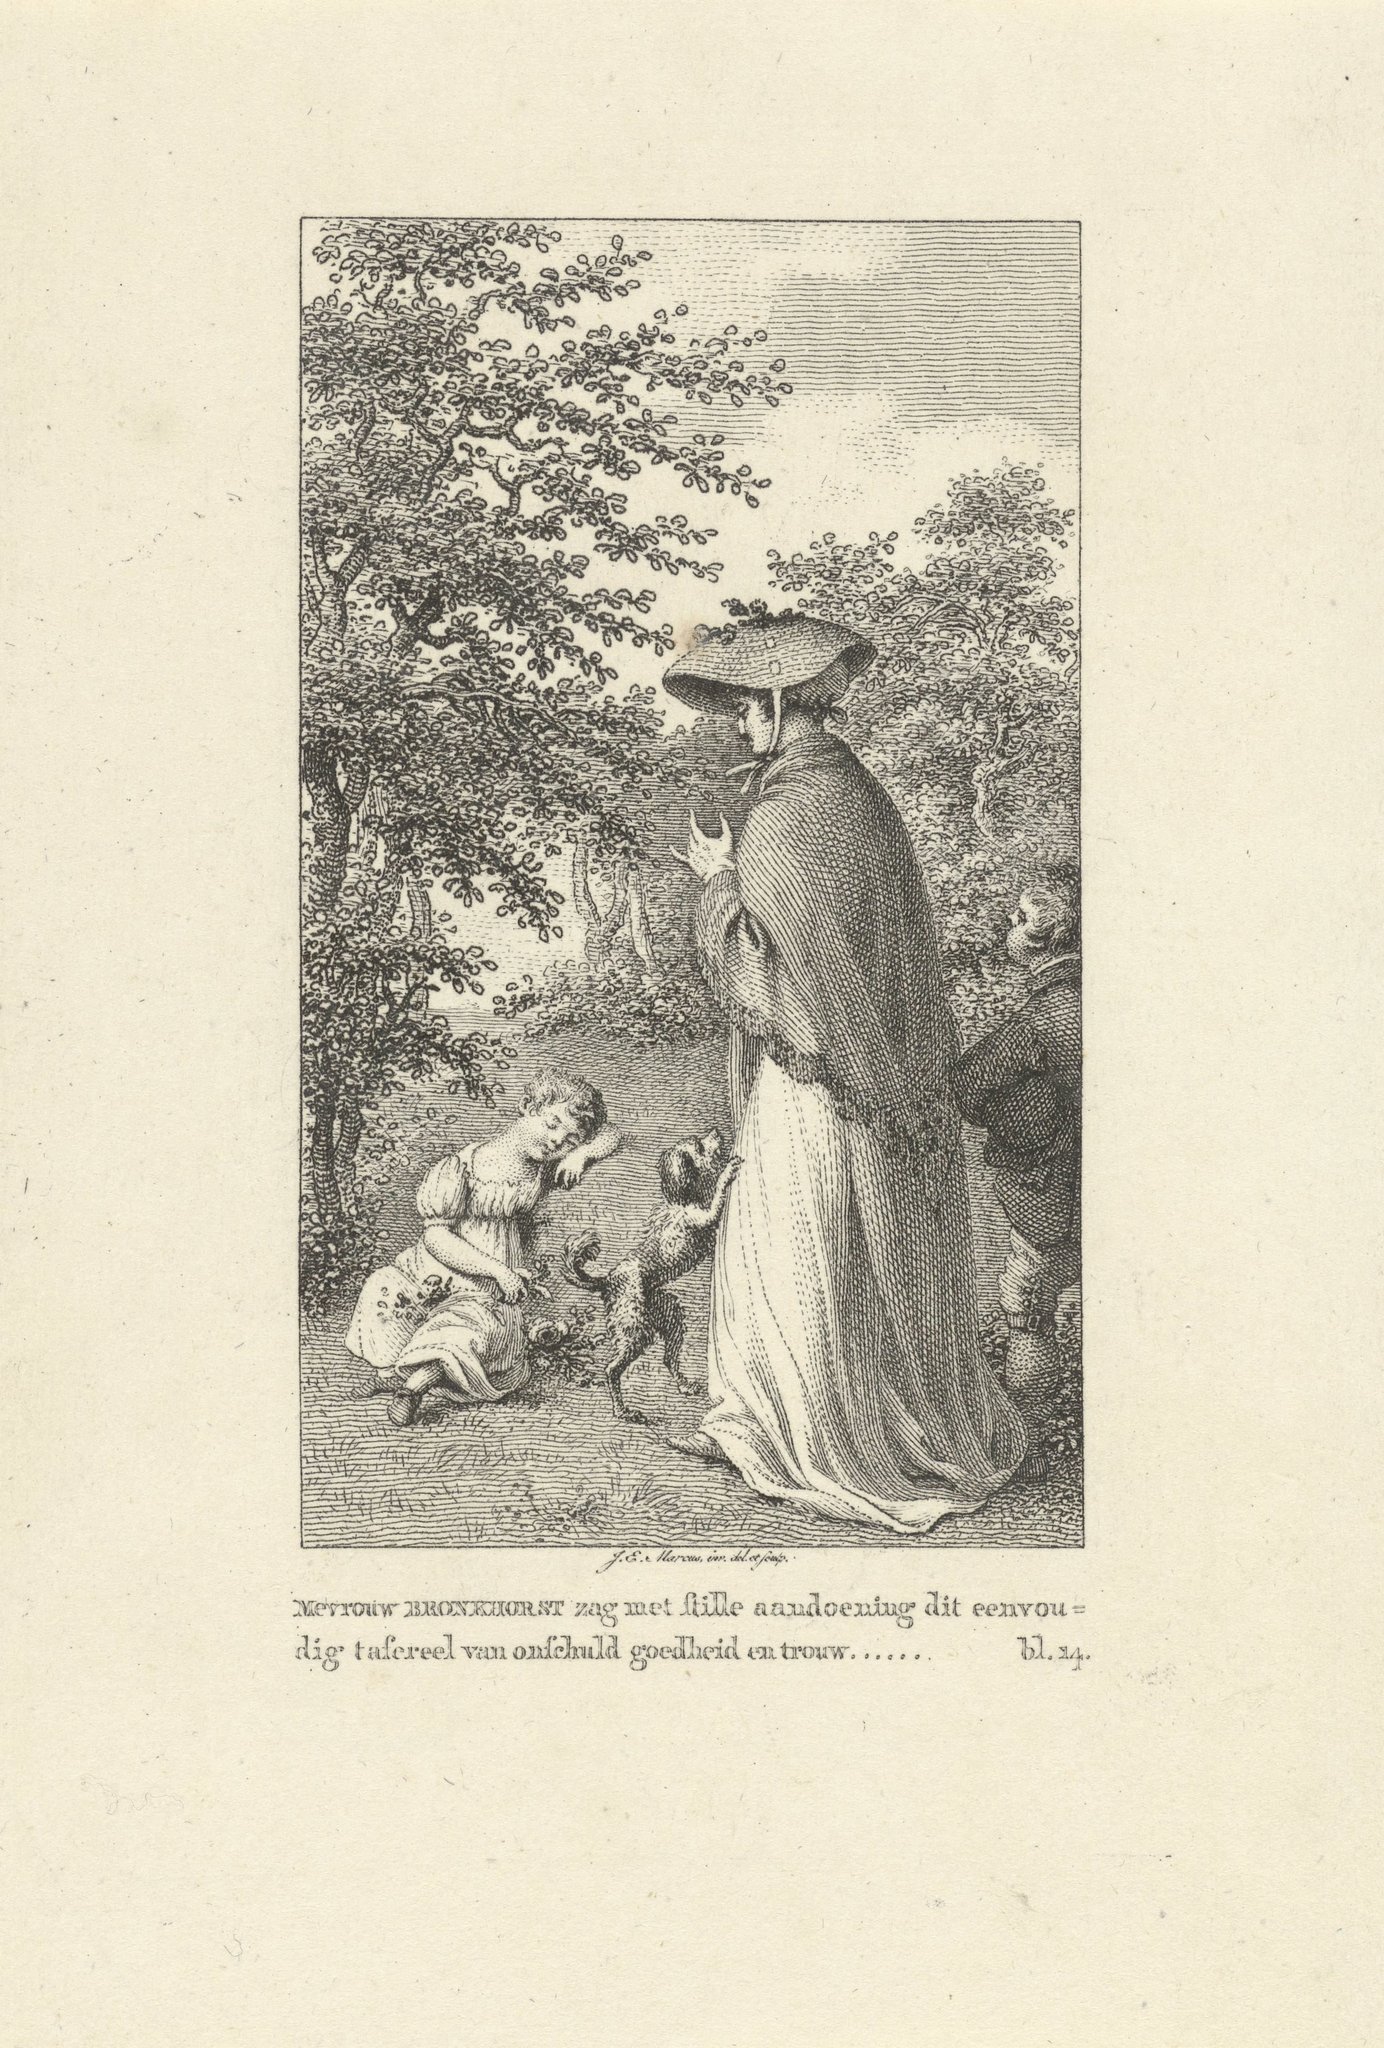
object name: book illustration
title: Mevrouw Bronkhorst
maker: jacob ernst marcus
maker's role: draughtsman, print maker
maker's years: 1774-1826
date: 1806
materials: paper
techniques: engraving, etching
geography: amsterdam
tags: sleeping on the ground - bb - out of doors, dog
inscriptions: collector's mark: Lugt 2228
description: Prent mogelijk gebruikt in: Adriaan Pietersz Loosjes. Historie van Mejuffrouw Susanna Bronkhorst. Haarlem: A. Loosjes Pz.,1806. Prent mogelijk gebruikt in: Petronella Moens. De kleine Suse Bronkhorst. Haarlem: A. Loosjes Pz., 1808.